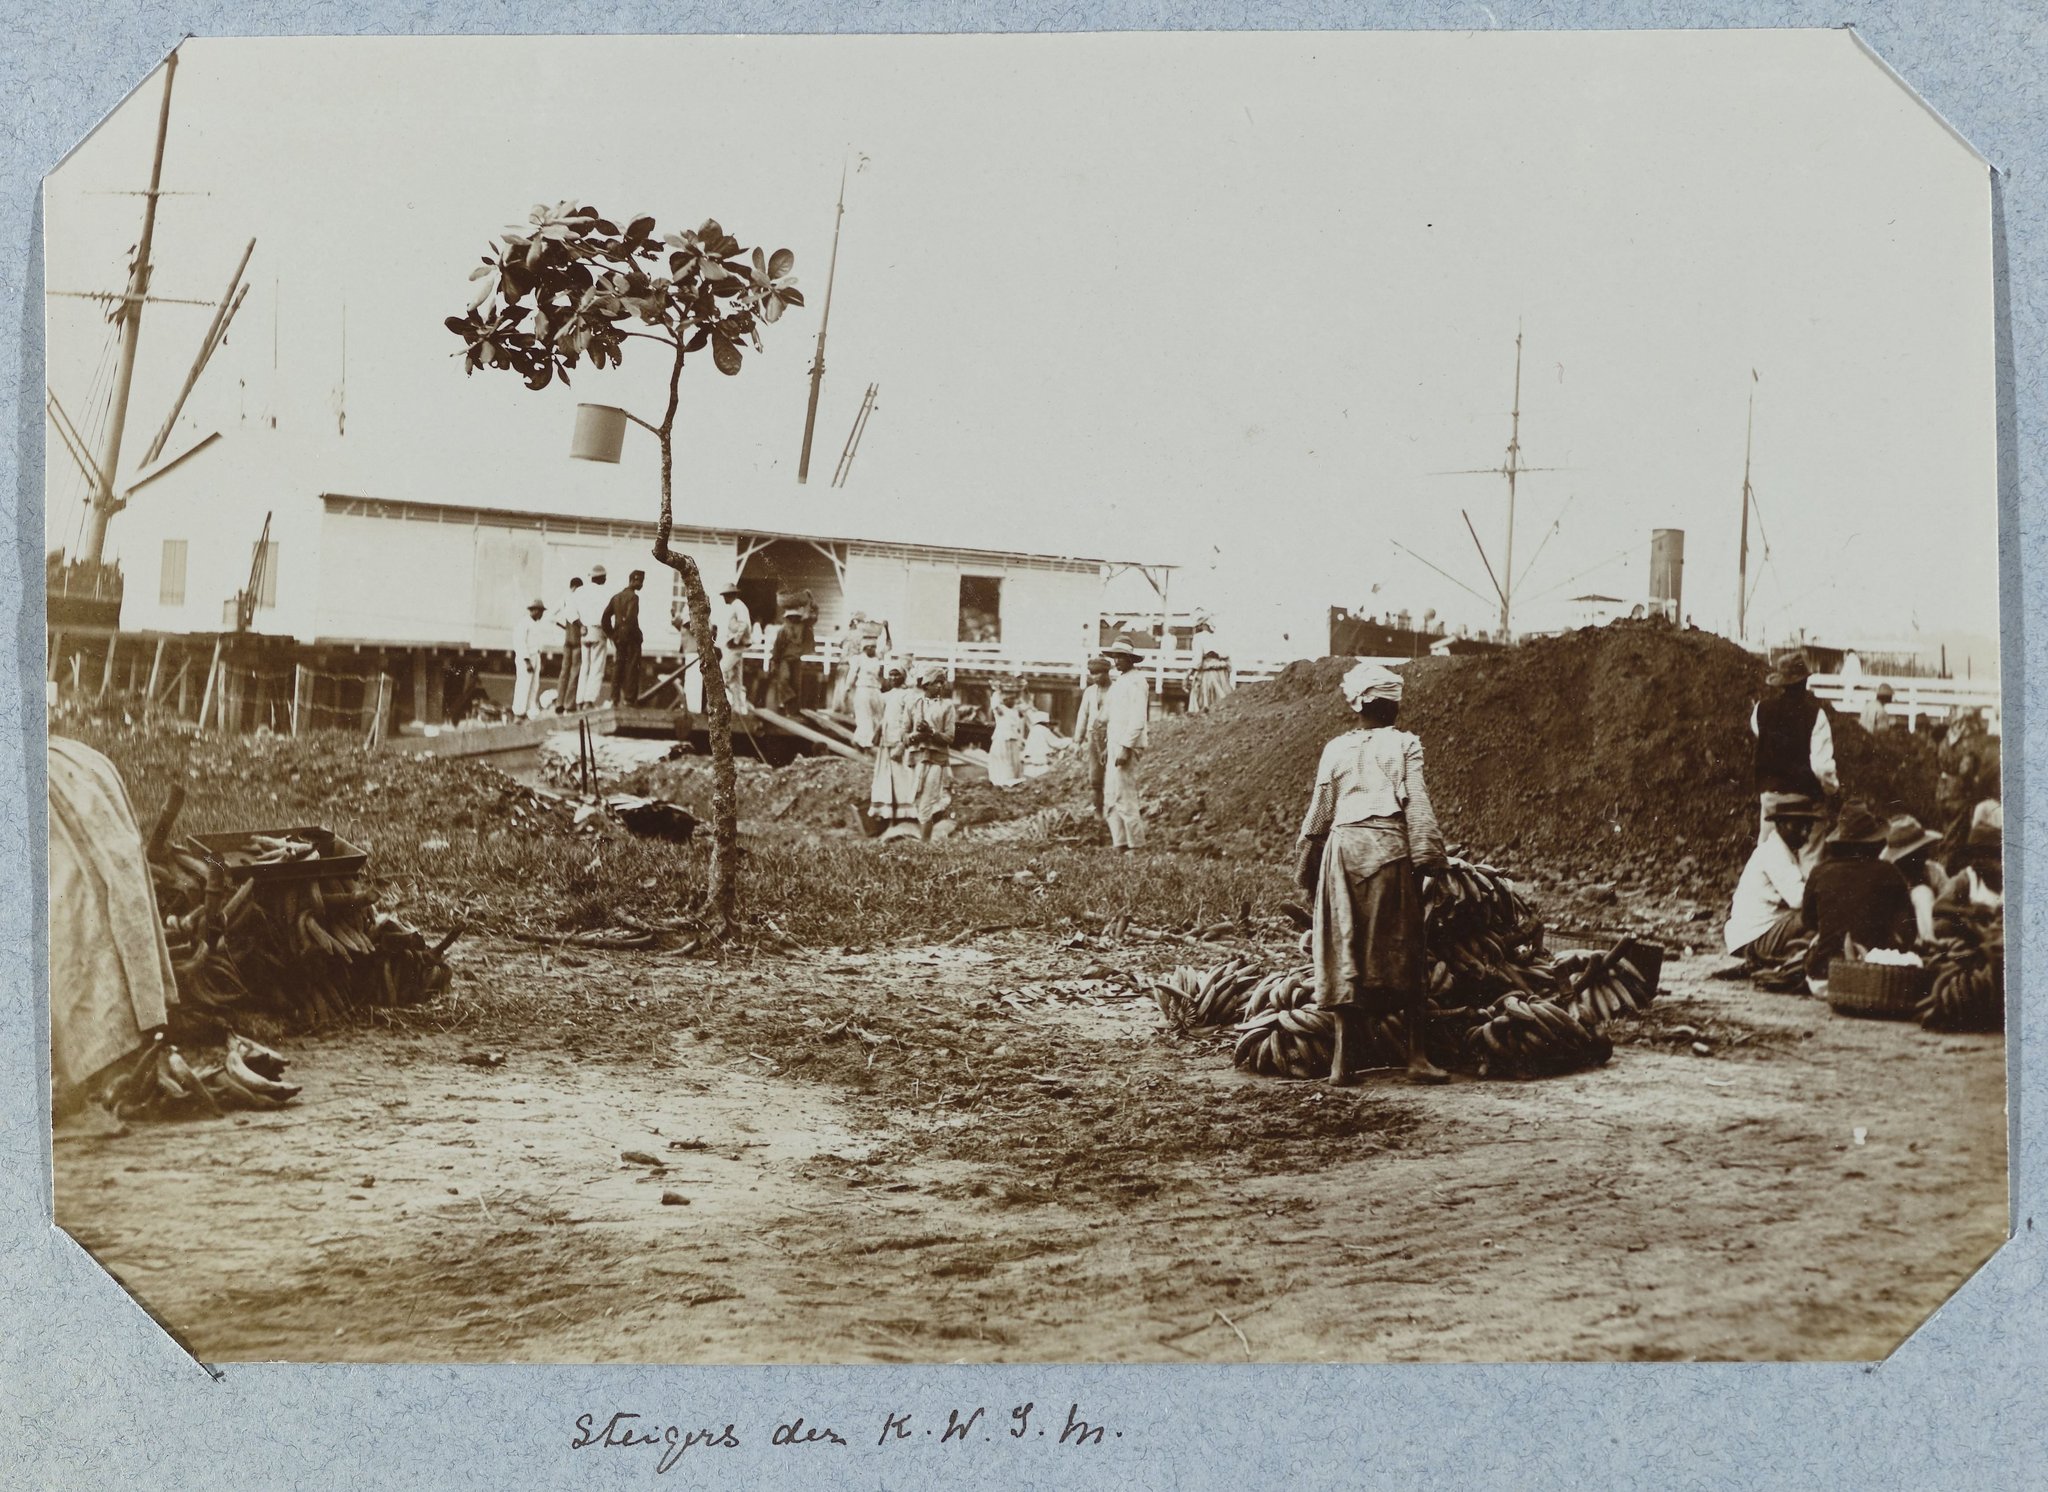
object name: photograph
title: Steiger der K.W.I.M.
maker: théodore van lelyveld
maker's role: painter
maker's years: 1867-1954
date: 1895-1898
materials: photographic support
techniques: collodion silver print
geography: suriname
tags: pier, quay, wharf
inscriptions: inscription: ‘Steiger der K.W.I.M.’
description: Een schip aan de steiger van de K.W.I.M. (Koninklijke West-Indische Maildienst) aan de Waterkant te Paramaribo. Op de voorgrond liggen trossen bananen voor verscheping. Fotoafdruk in een fotoalbum van Théodore van Lelyveld over Suriname uit 1895-1898.